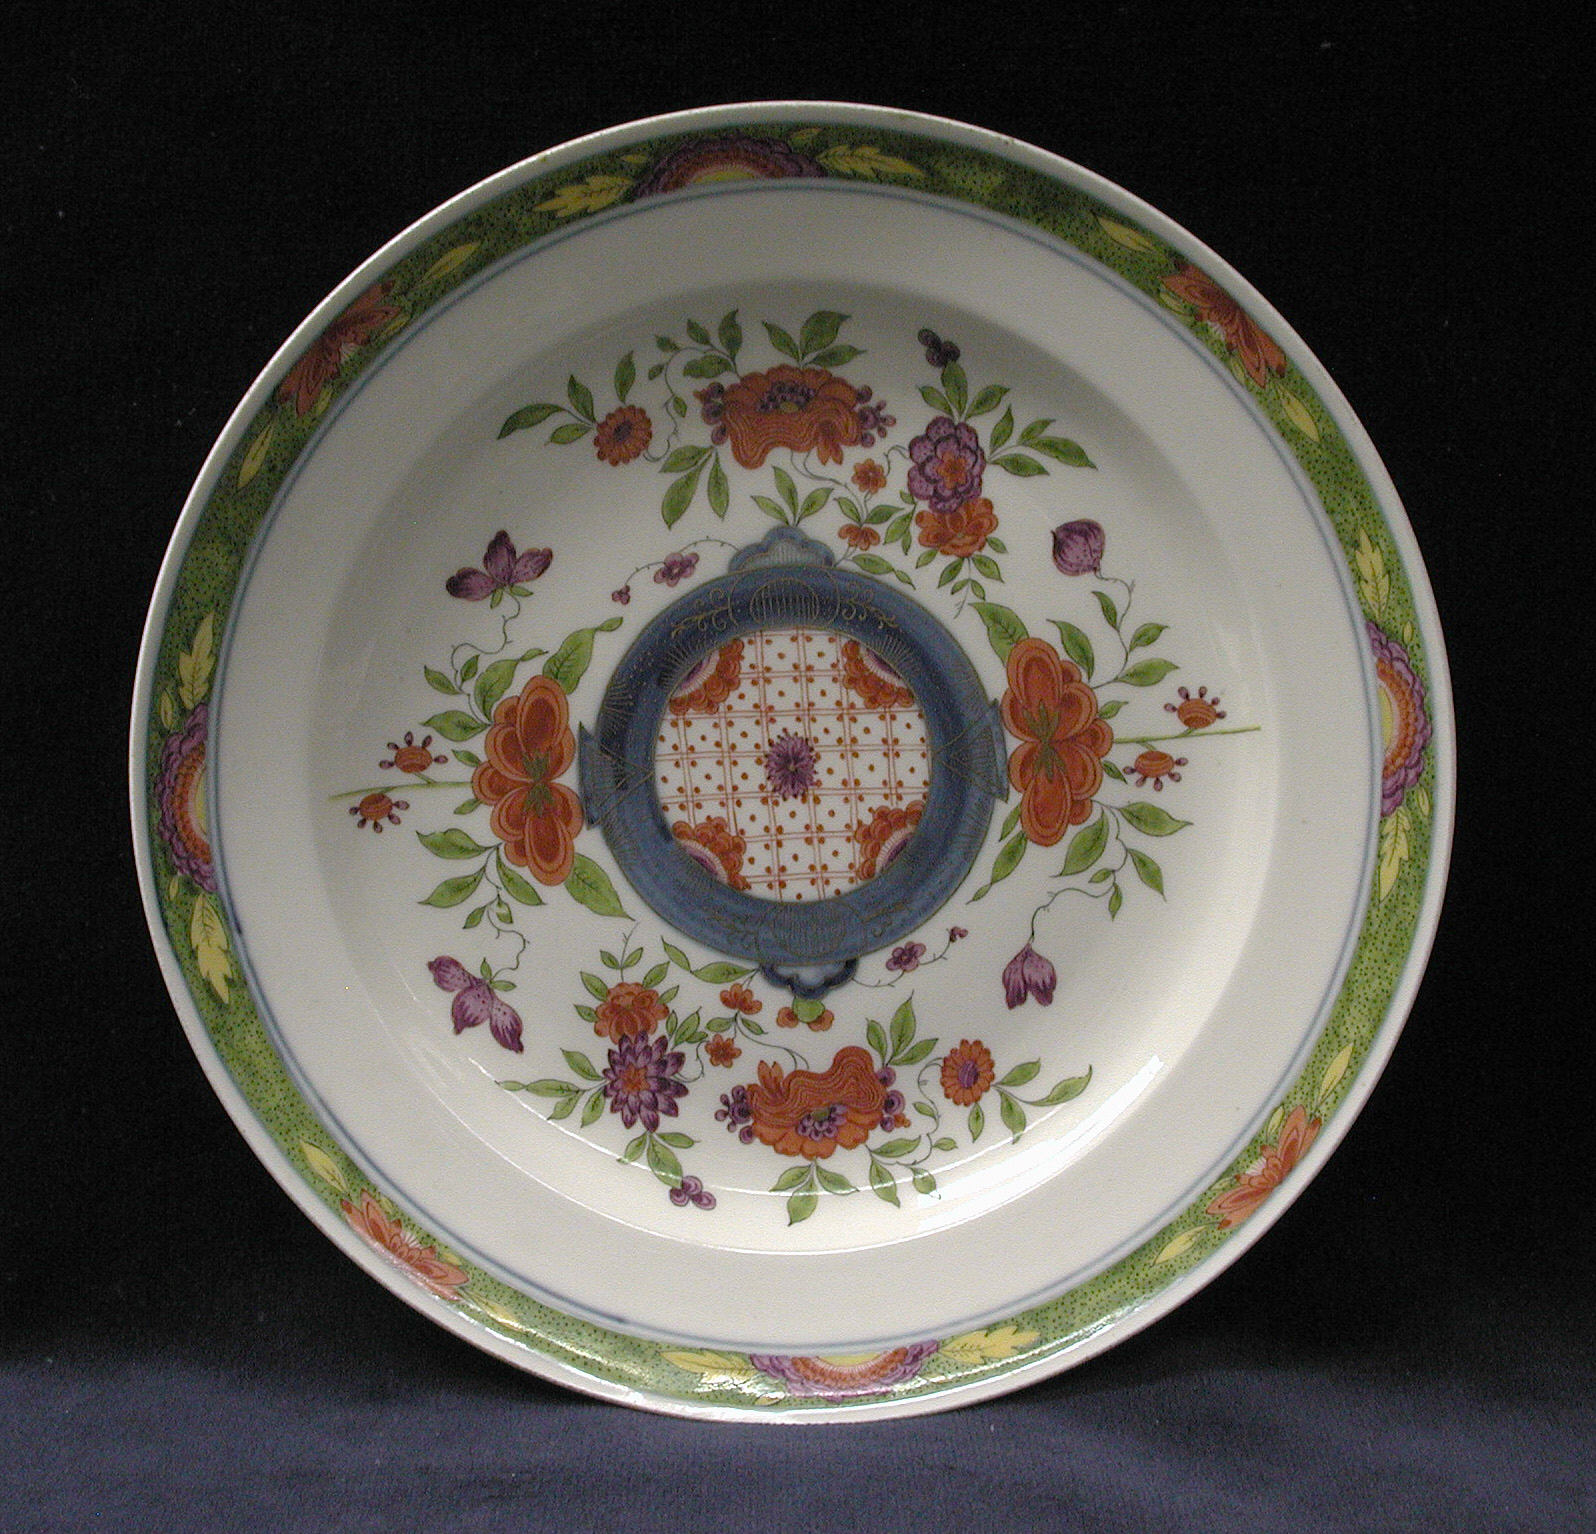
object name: plate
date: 1801-1900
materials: hard paste porcelain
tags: flowers